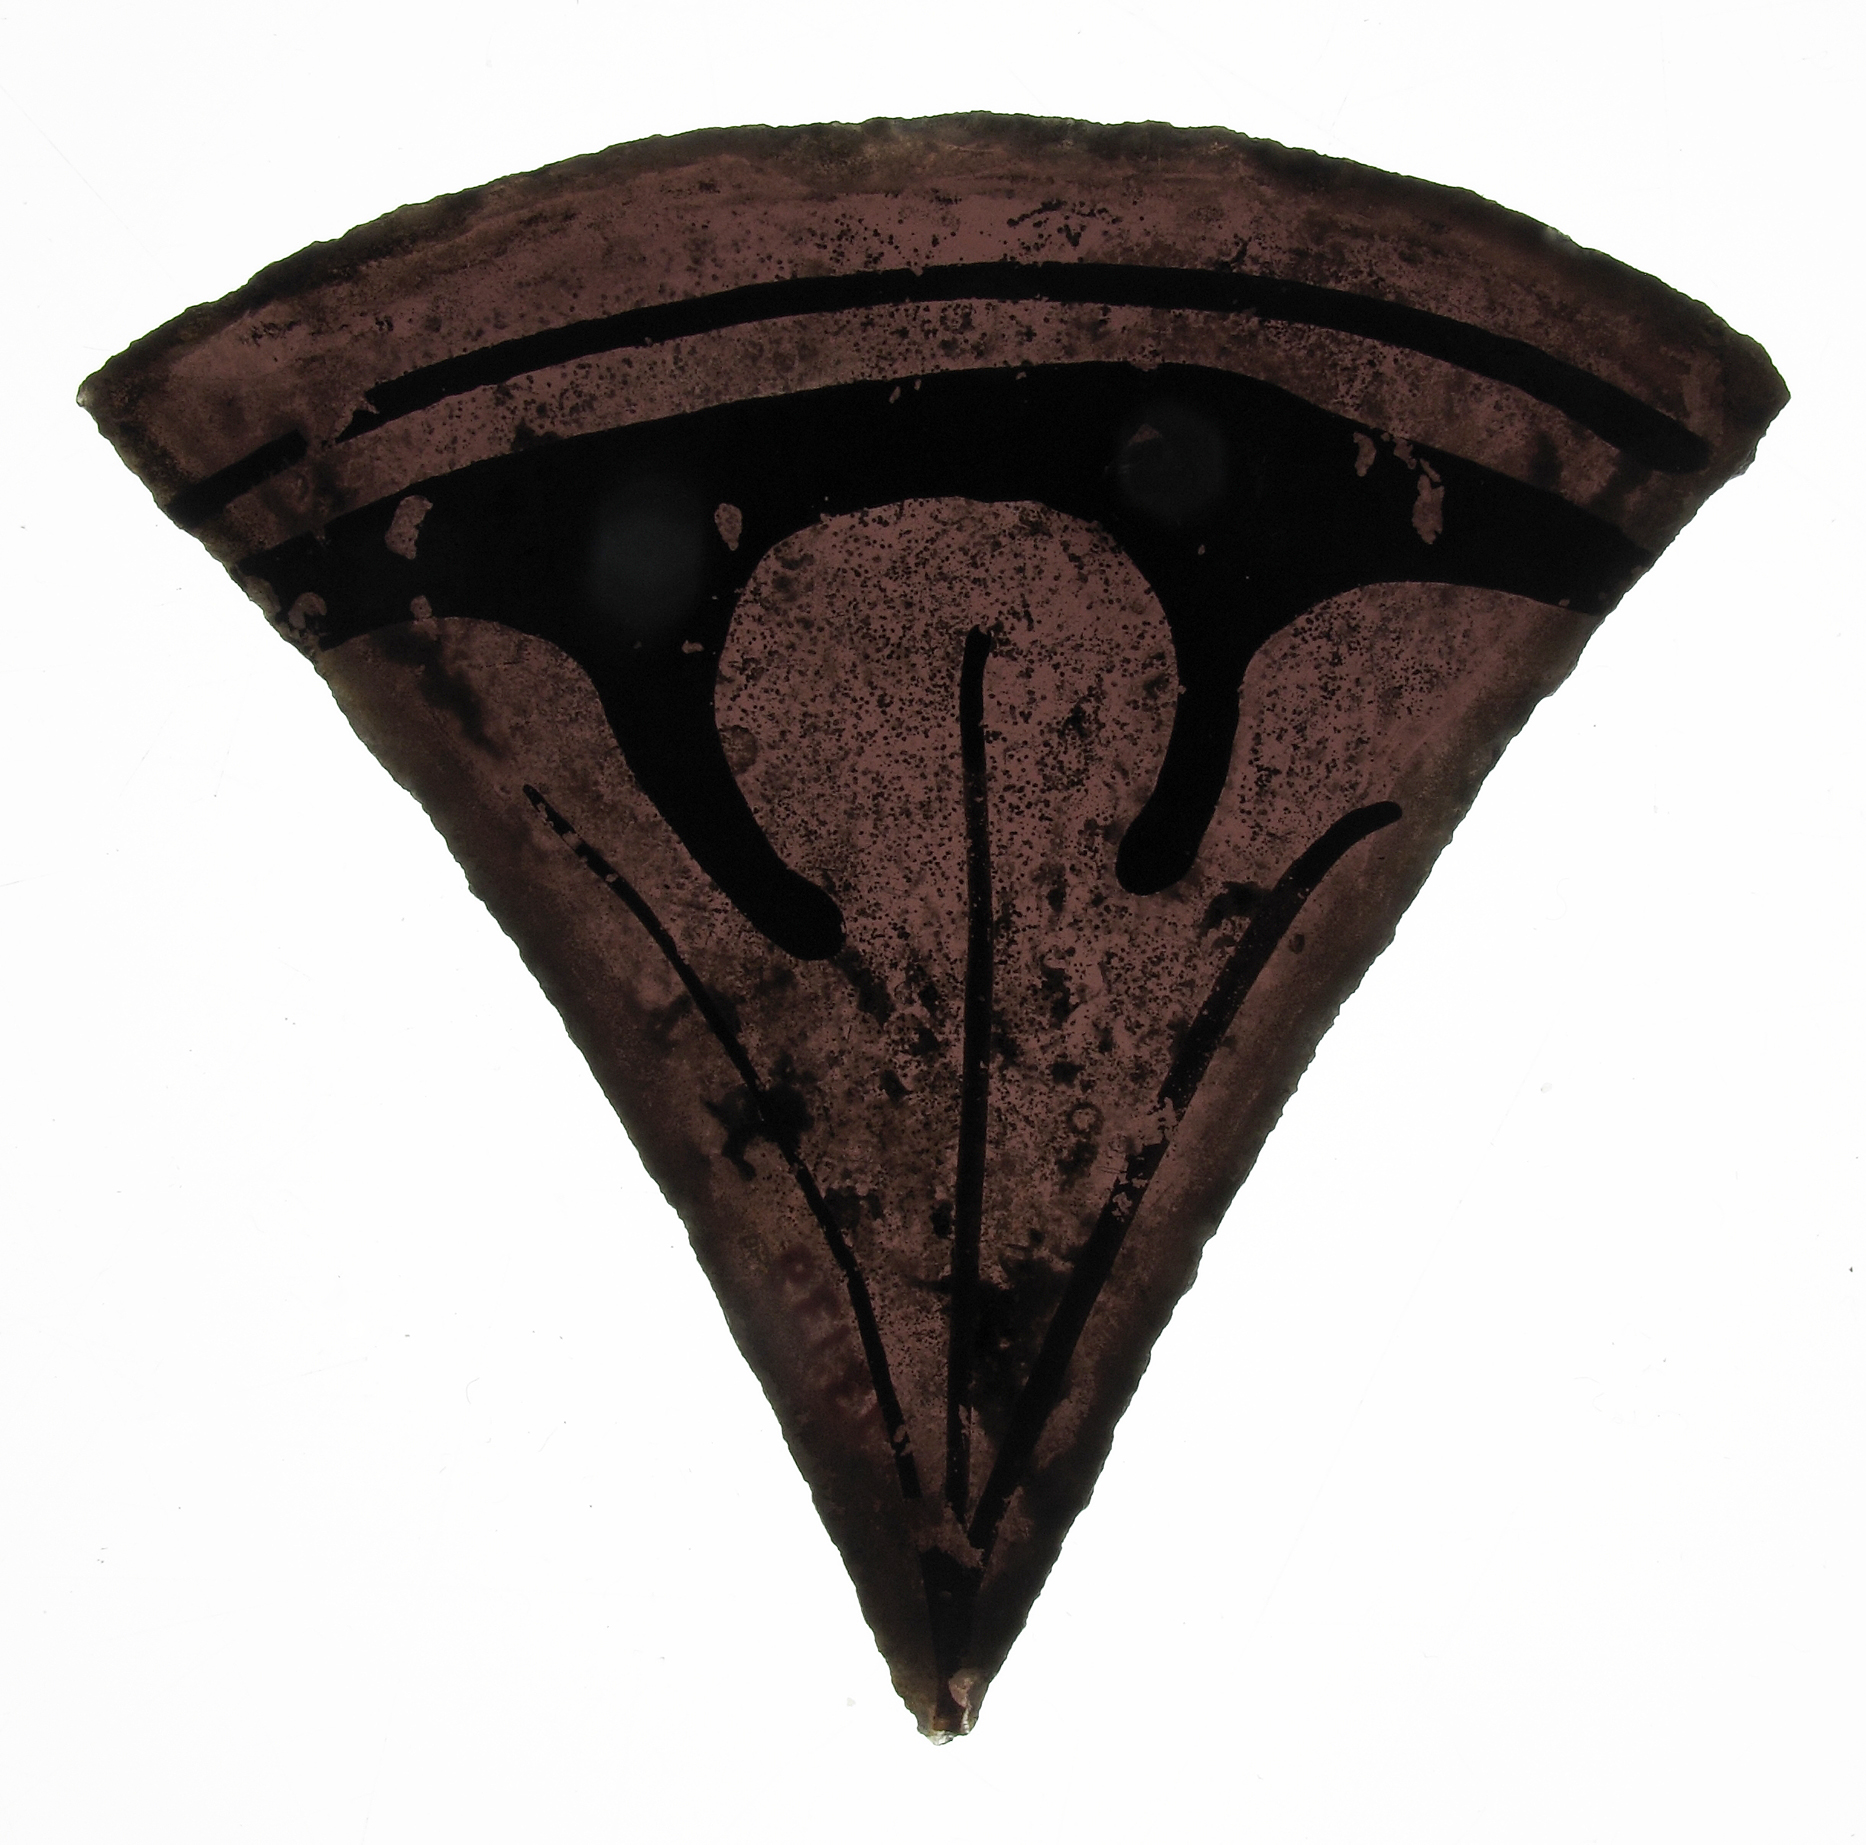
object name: fragment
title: Glass Fragment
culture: european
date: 1301-1400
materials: glass, metal